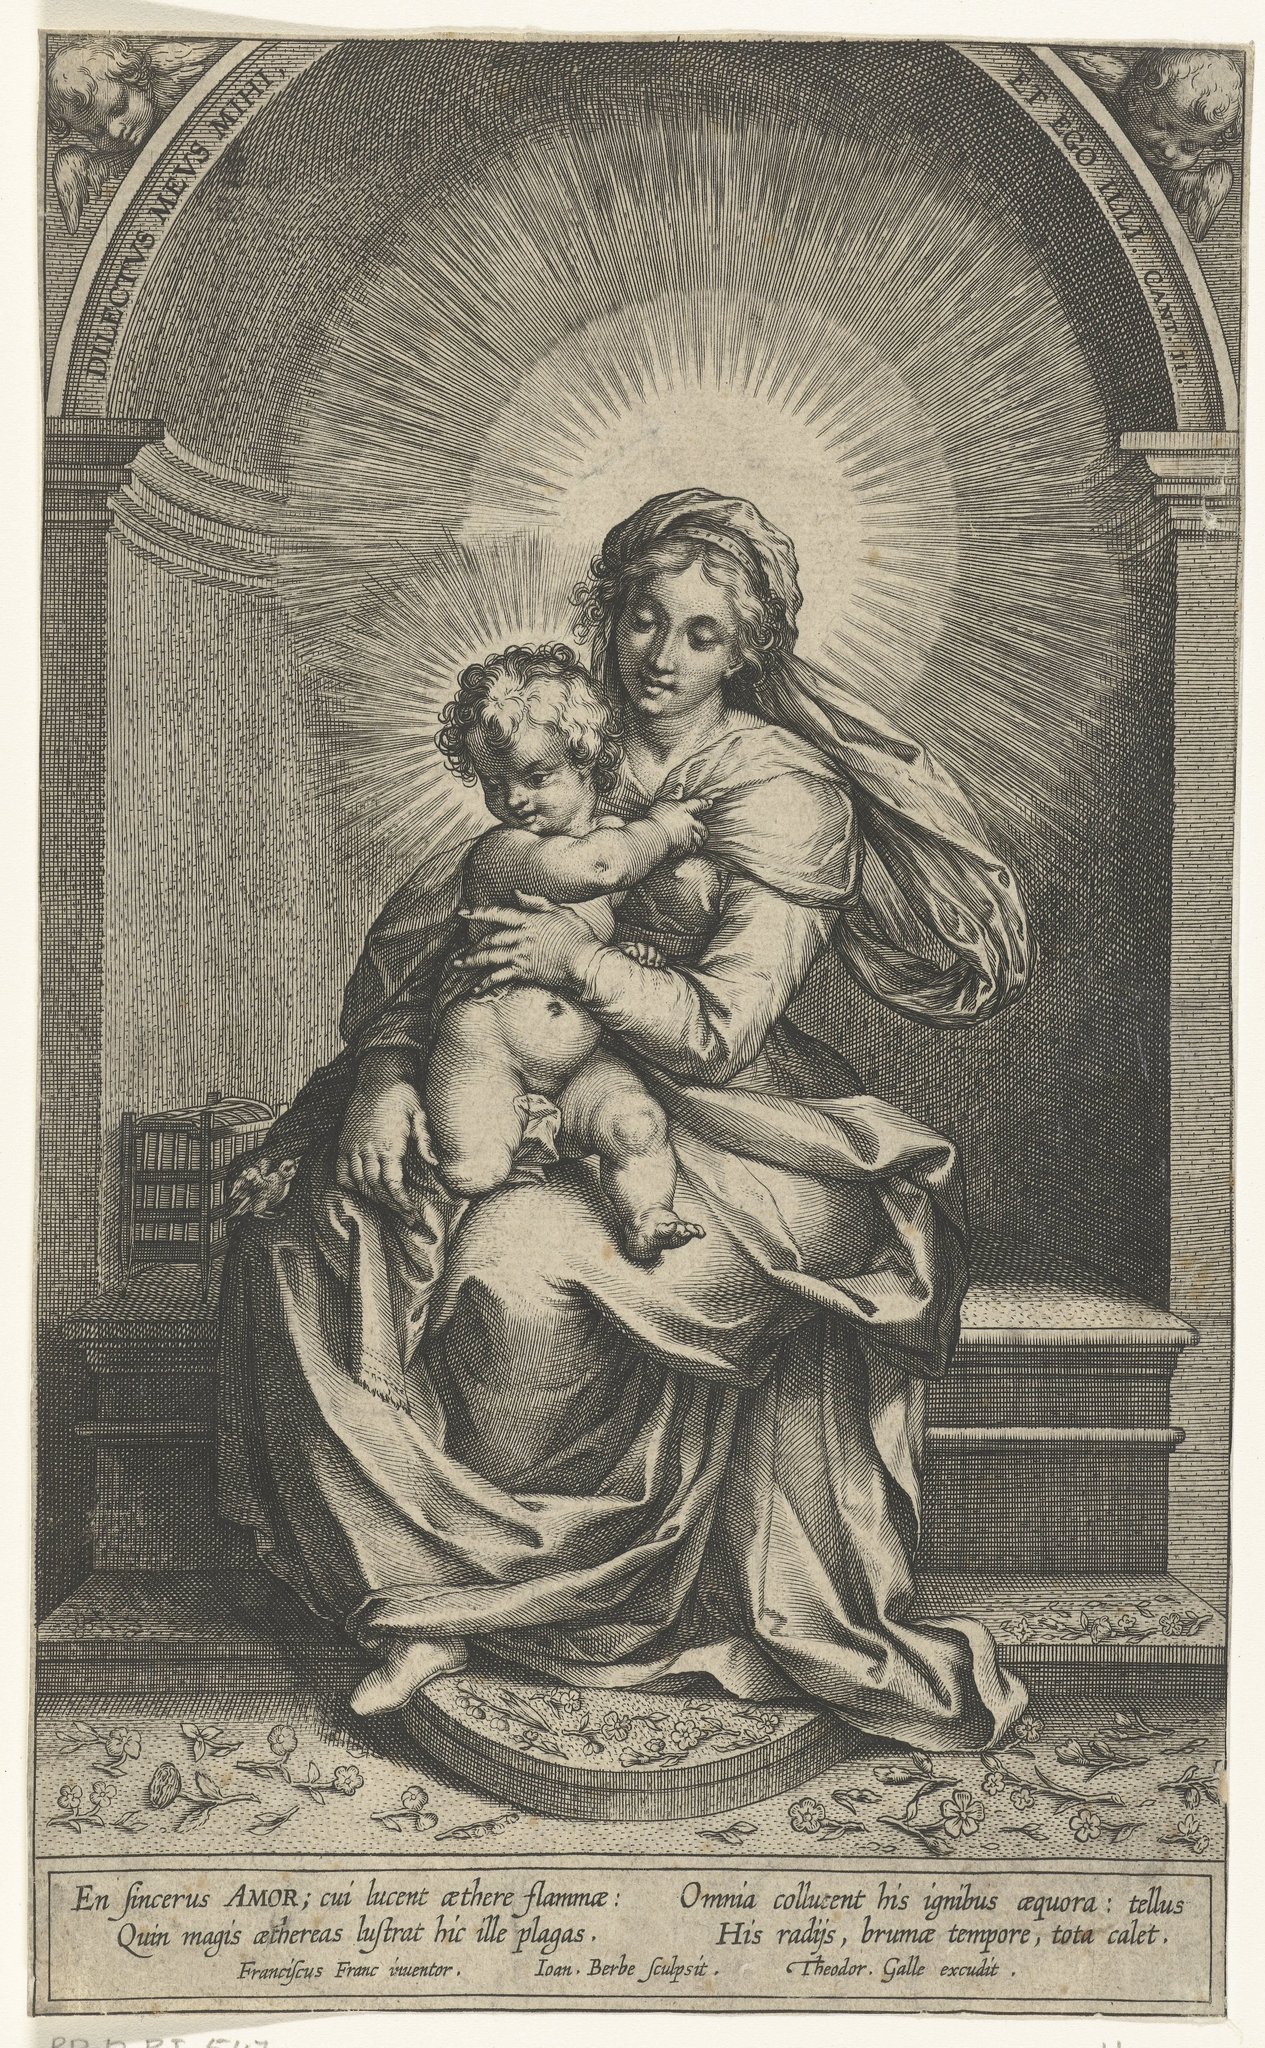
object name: print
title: Tronende Maria met Kind en kleine vogel op schoot in nis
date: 1588-1648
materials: paper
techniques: engraving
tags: christ-child holding something in his hand, e.g. apple, bird, cherries, crucifix, grapes, paper wind-mill ~ madonna-representations, song of solomon, song of songs (with book chapter:verse), mary sitting or enthroned, the christ-child in front of her, sitting in her lap (or in front of her bosom)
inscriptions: collector's mark: Lugt 240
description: Maria met Kind zit in nis met naast haar kleine vogelkooi en op haar knie een vogel waarnaar het Christuskind kijkt. Voor haar voeten liggen rozen. Op de boog van de nis en onder de voorstelling staan Latijnse opschriften die verwijzen naar de liefde en geliefden (Hooglied 2, vers 16).